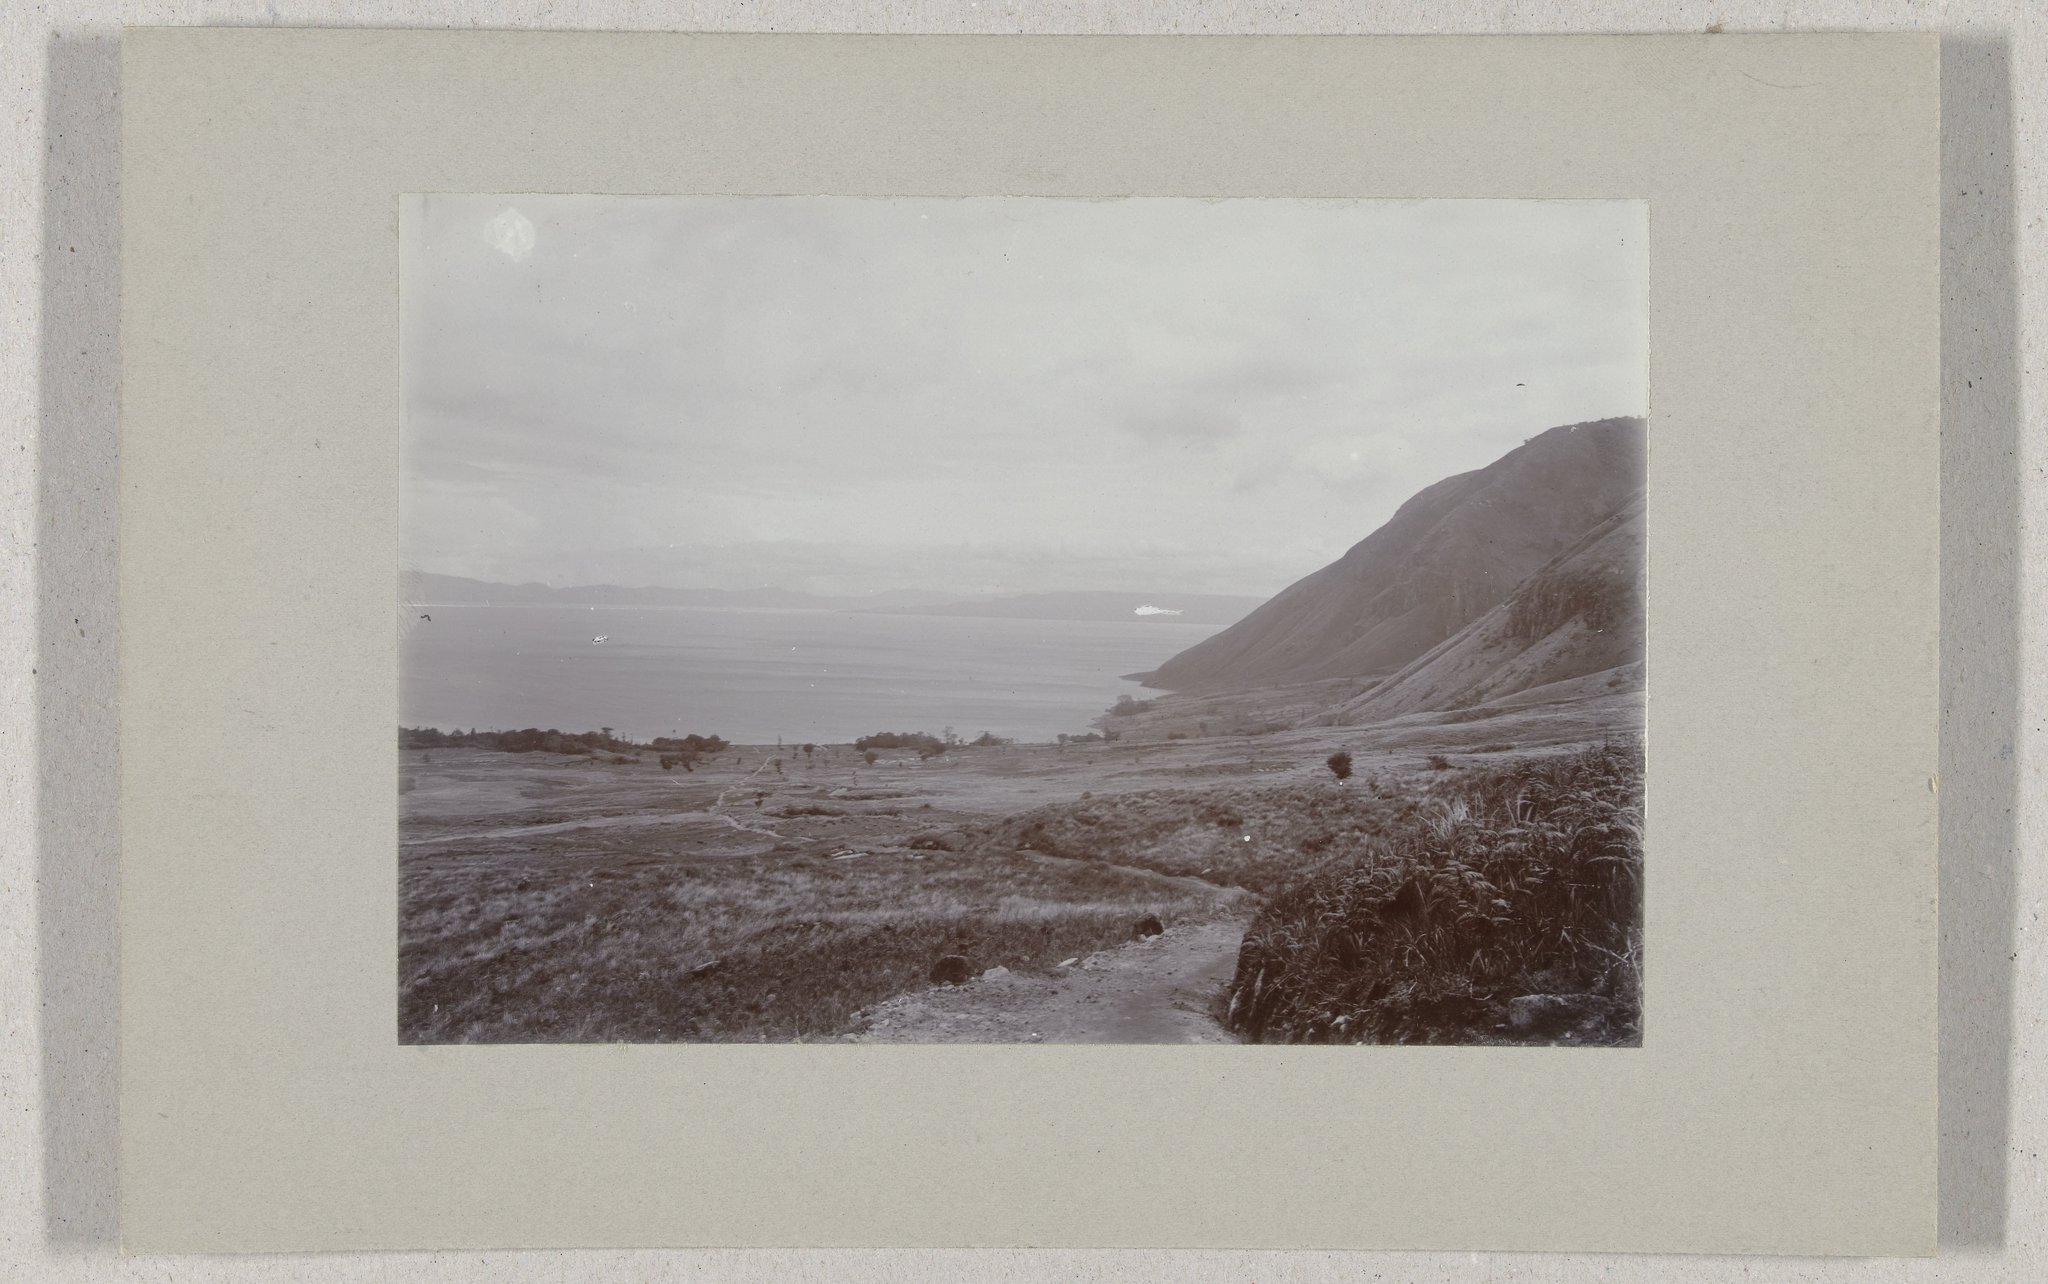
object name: photograph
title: Gezicht op het Tobameer op Sumatra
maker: Anonymous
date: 1895-1915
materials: cardboard, paper, photographic support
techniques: gelatin silver print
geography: sumatra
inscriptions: annotation: ‘8a Tobameer’